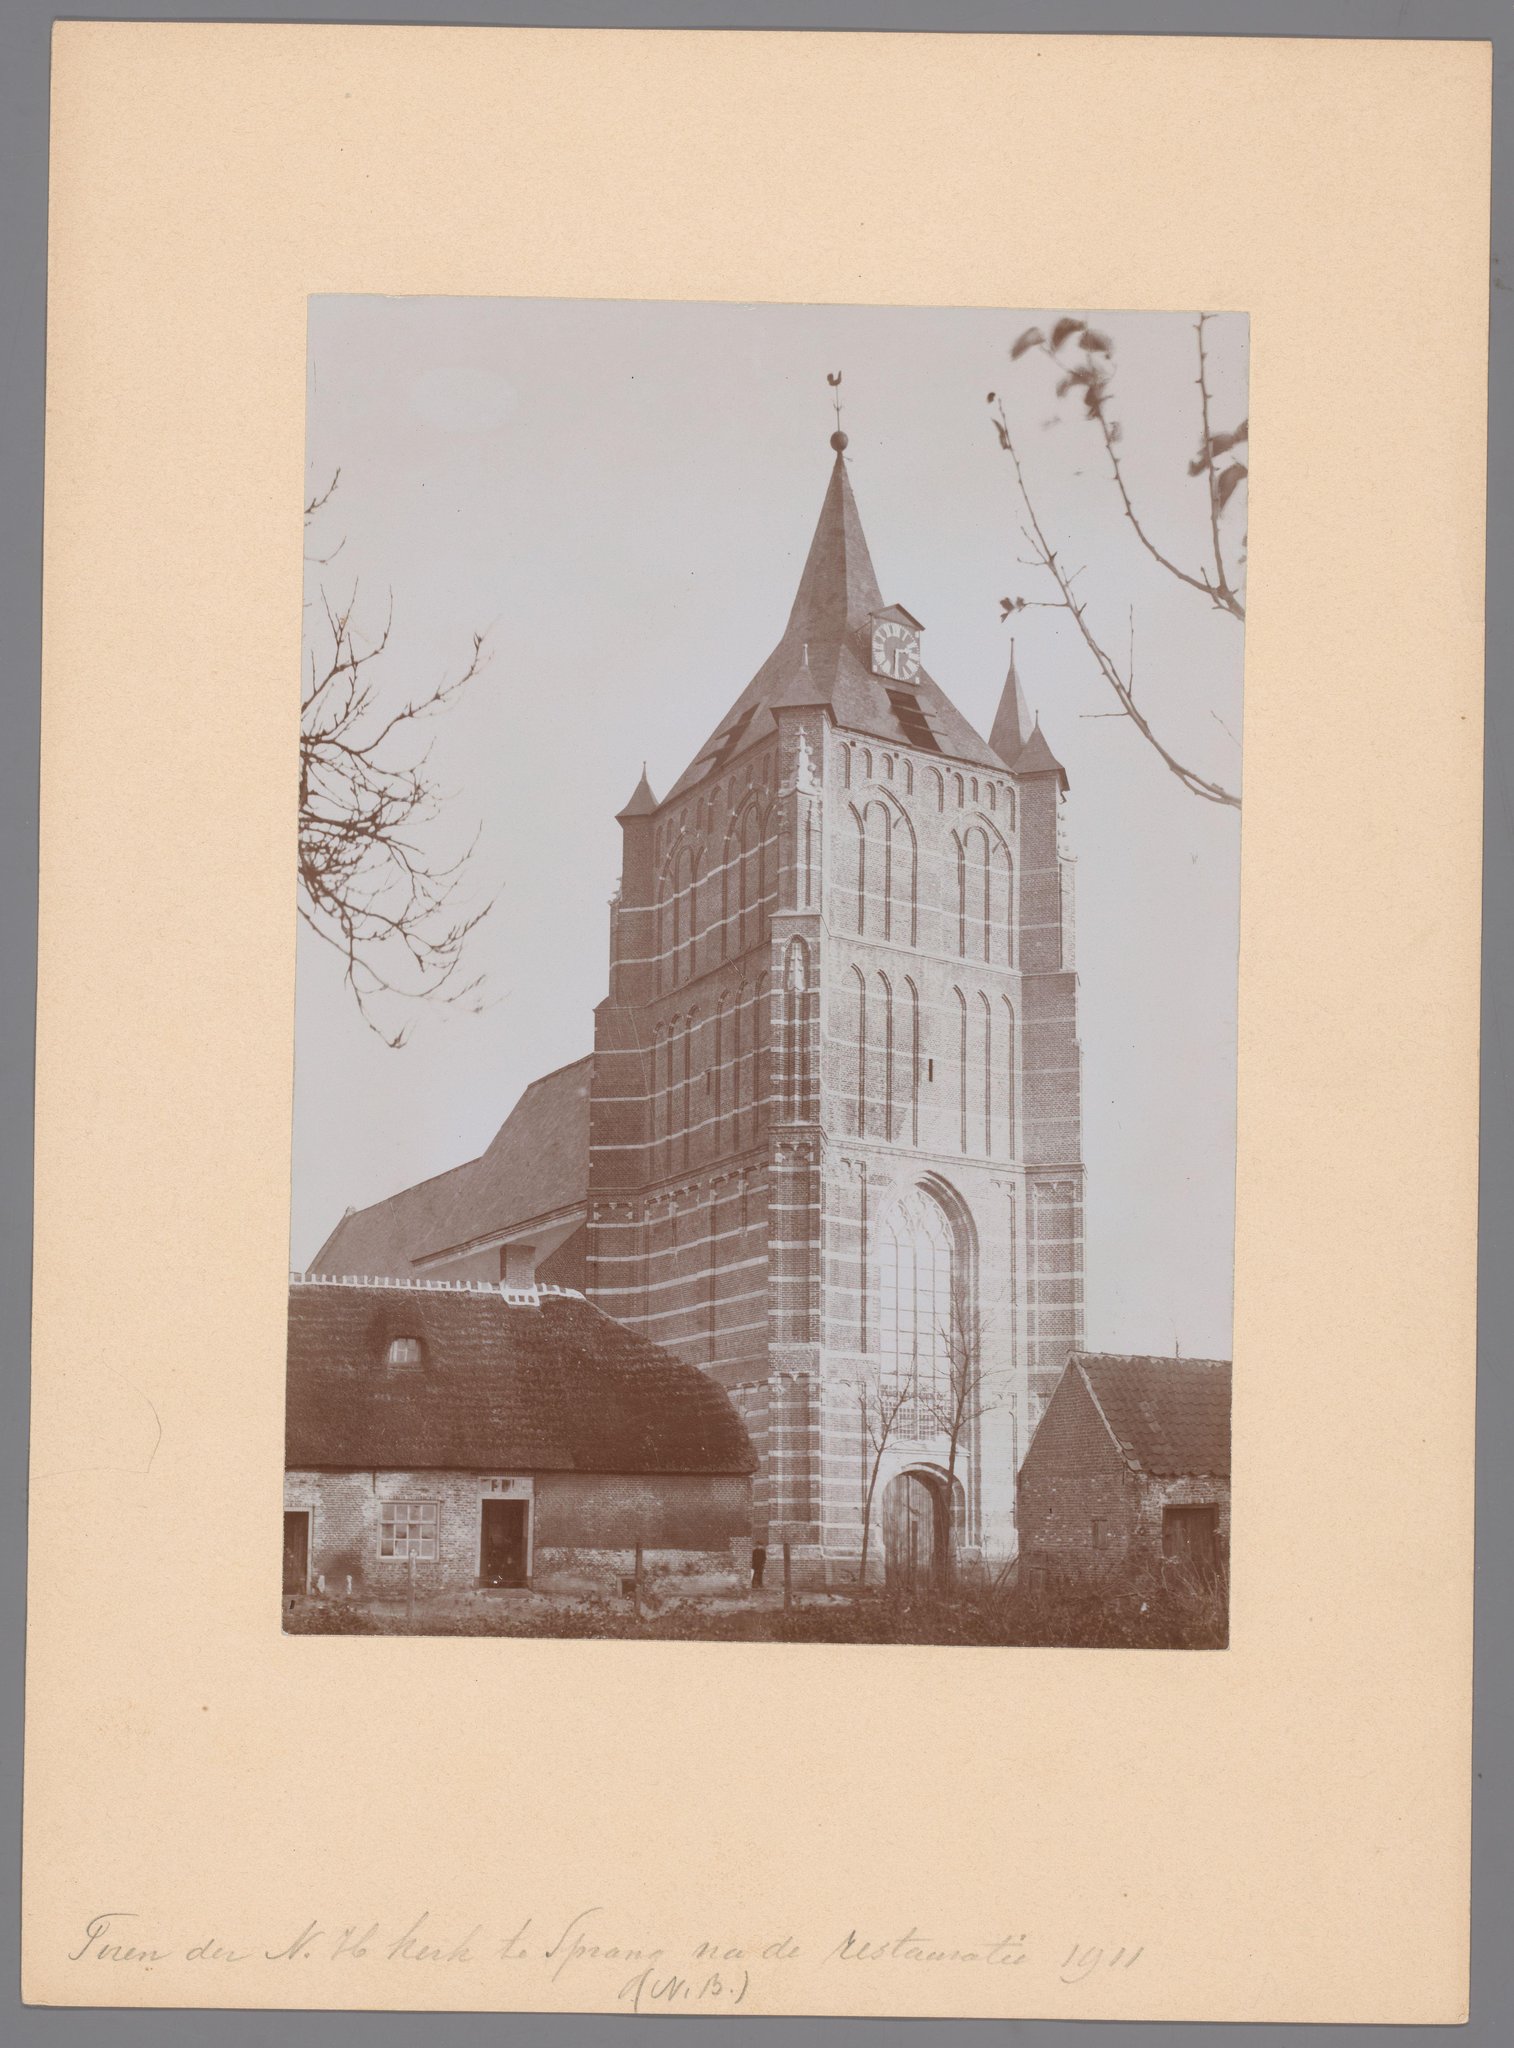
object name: photograph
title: Toren van de Hervormde Kerk te Sprang-Capelle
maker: anoniem (monumentenzorg)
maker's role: fotograaf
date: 1911-1920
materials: cardboard, photographic support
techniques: collodion silver print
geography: sprang-capelle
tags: parts of church exterior and annexes: tower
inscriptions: annotation: ‘J. Kuiper (praktiseer)’, annotation: ‘Toren der N.H. kerk te Sprang (N.B.) na de restauratie 1911’